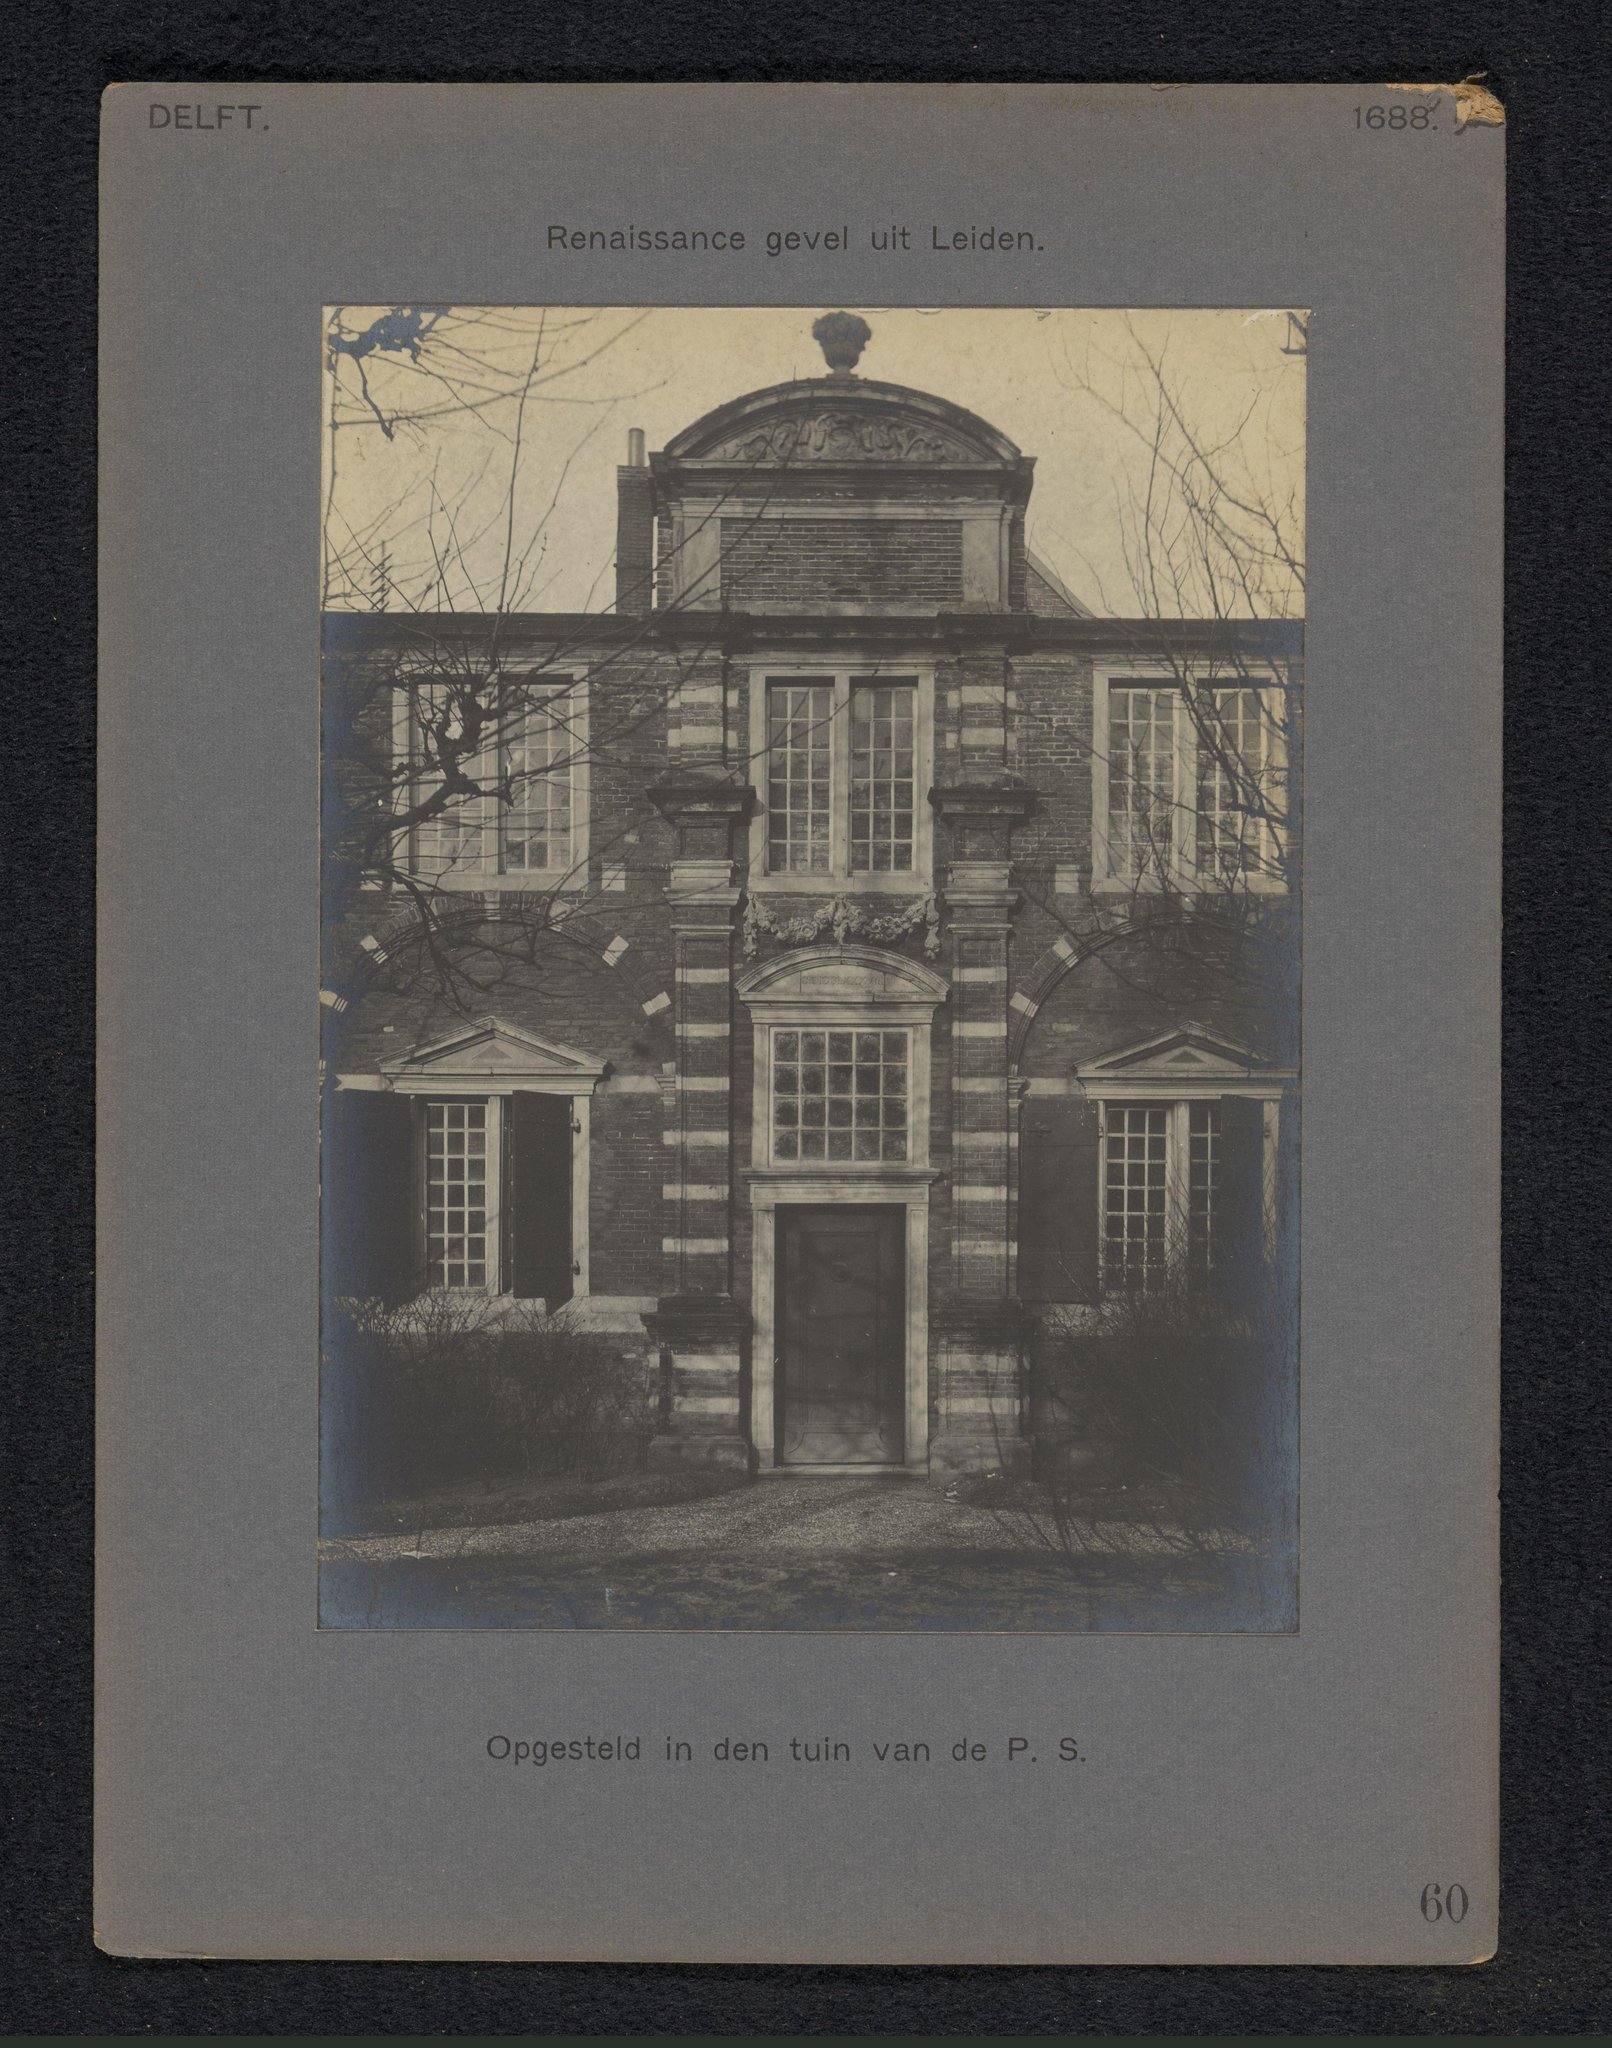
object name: photograph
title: Gevel in de tuin van het Prinsenhof in Delft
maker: Anonymous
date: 1900-1904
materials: cardboard, photographic support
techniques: gelatin silver print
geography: delft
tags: prinsenhof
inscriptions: inscription: ‘Delft. 1688.’, number: ‘60’, inscription: ‘Het recht van reproductie dezer photo's wordt door den Uitgever voorbehouden.’